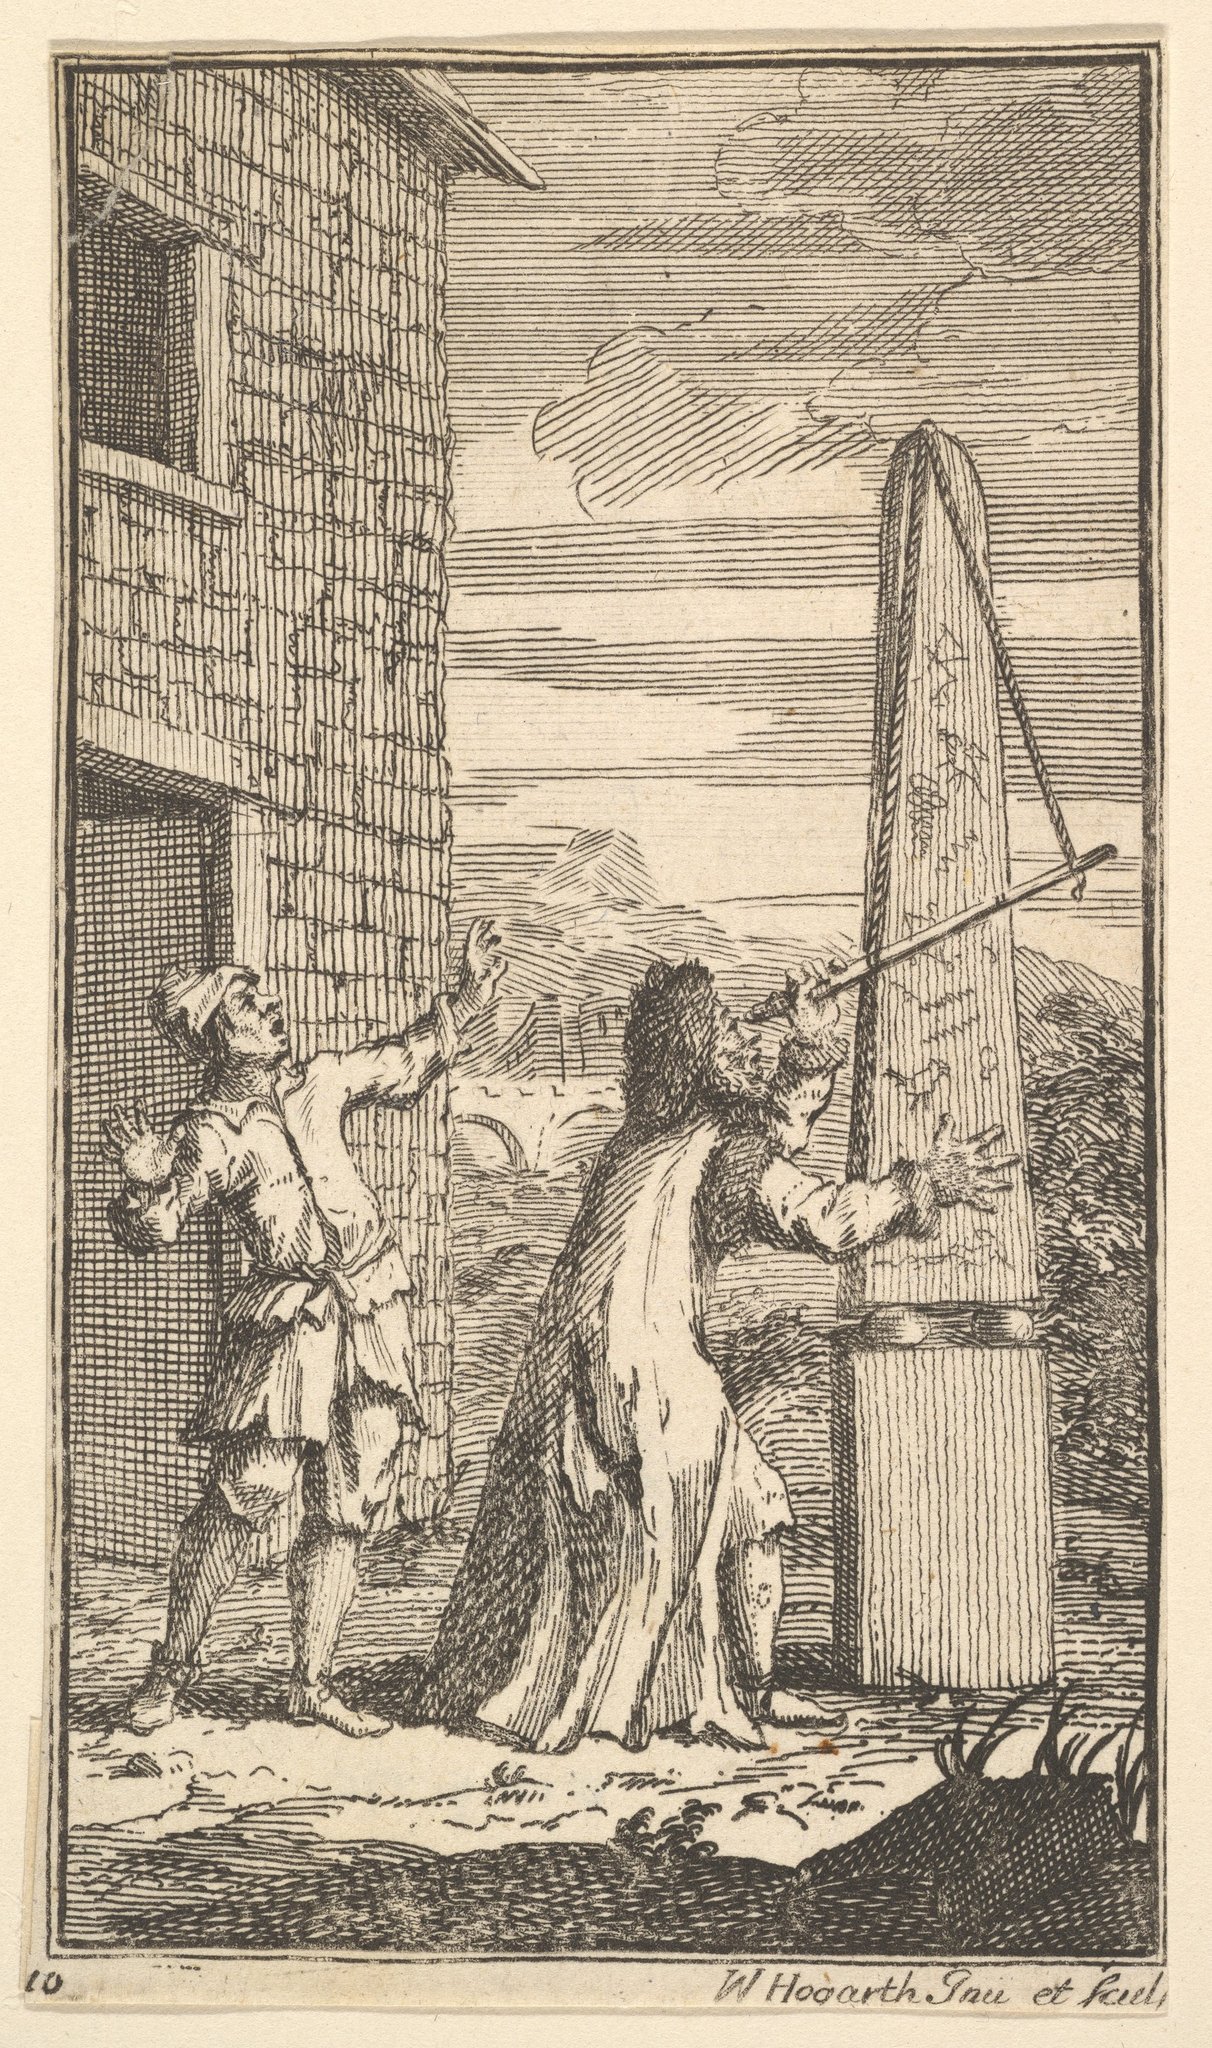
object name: print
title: Sidrophel Examining the Kite Through His Telescope (Seventeen Small Illustrations for Samuel Butler's Hudibras, no. 10)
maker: william hogarth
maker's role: artist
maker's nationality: british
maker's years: 1697-1764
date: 1721-1726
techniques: engraving, etching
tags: science,obelisks,men,telescopes